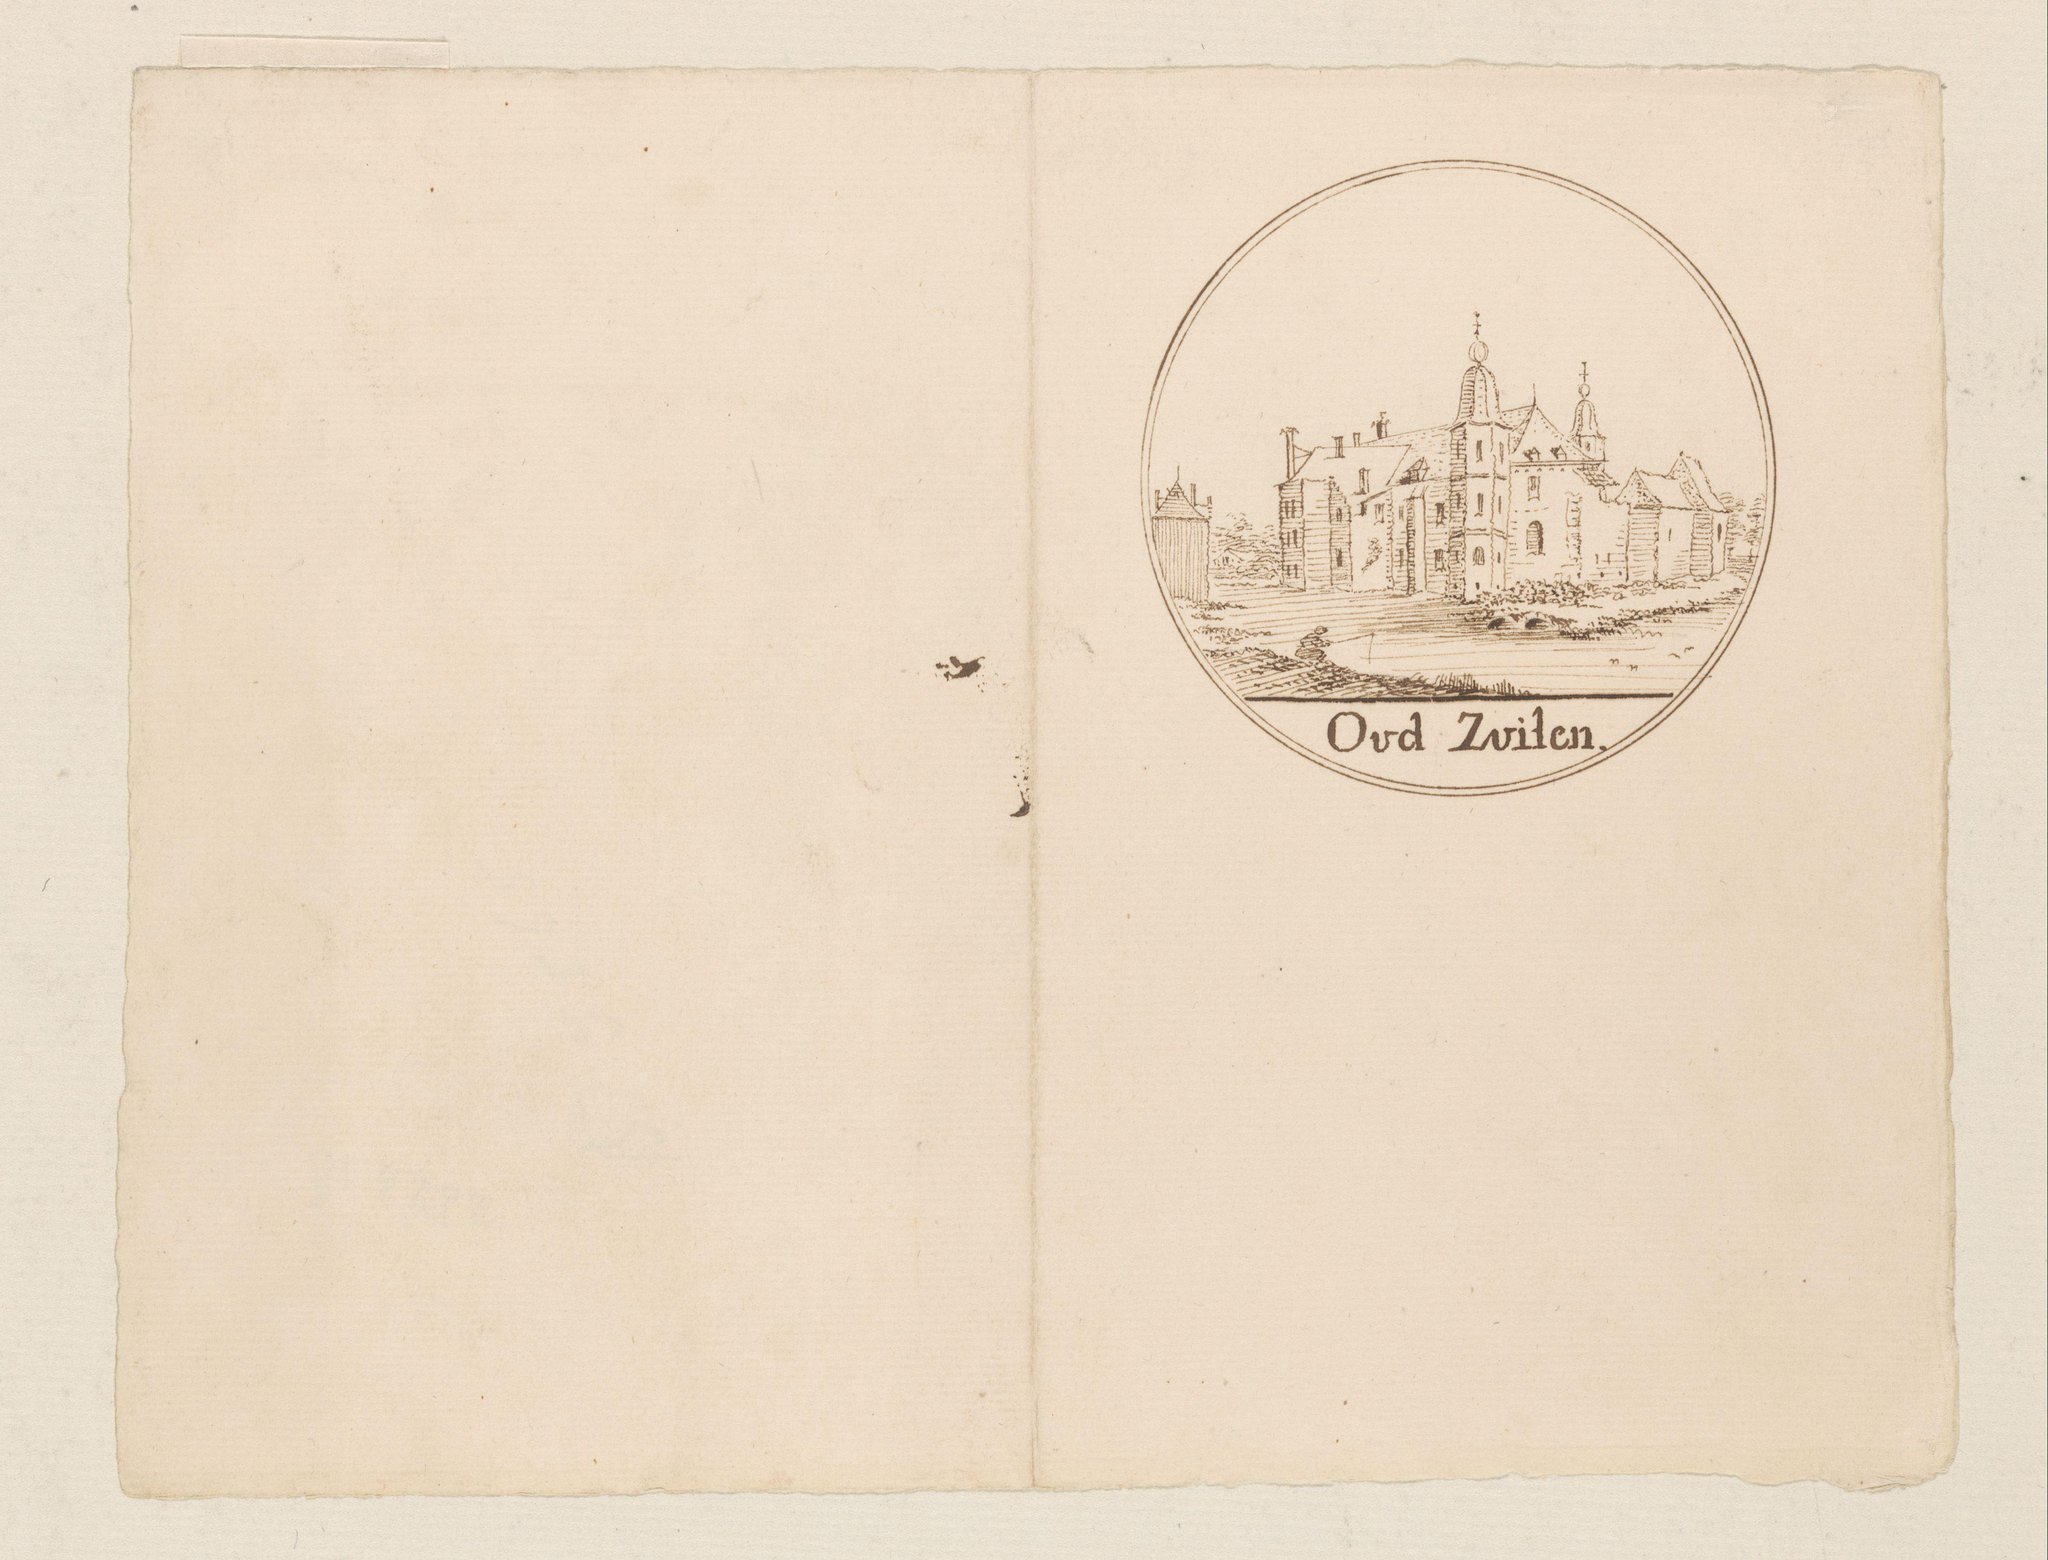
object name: drawing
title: Gezicht op Slot Zuylen in Oud-Zuilen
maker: Anonymous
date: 1750-1850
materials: ink, paper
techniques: drawing, pen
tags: castle, landscape with tower or castle